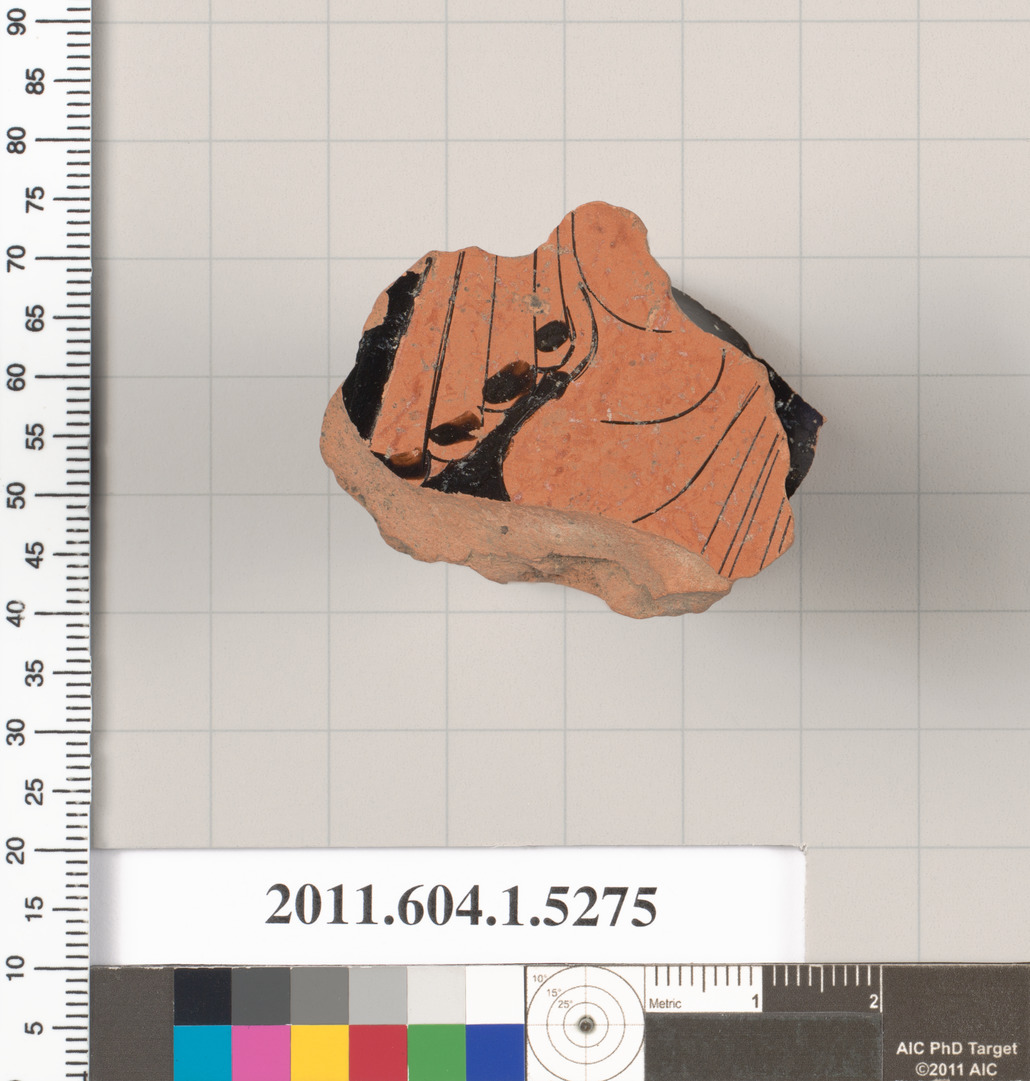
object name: kylix fragment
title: Terracotta fragment of a kylix (drinking cup)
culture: greek, attic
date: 475-451 BCE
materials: terracotta